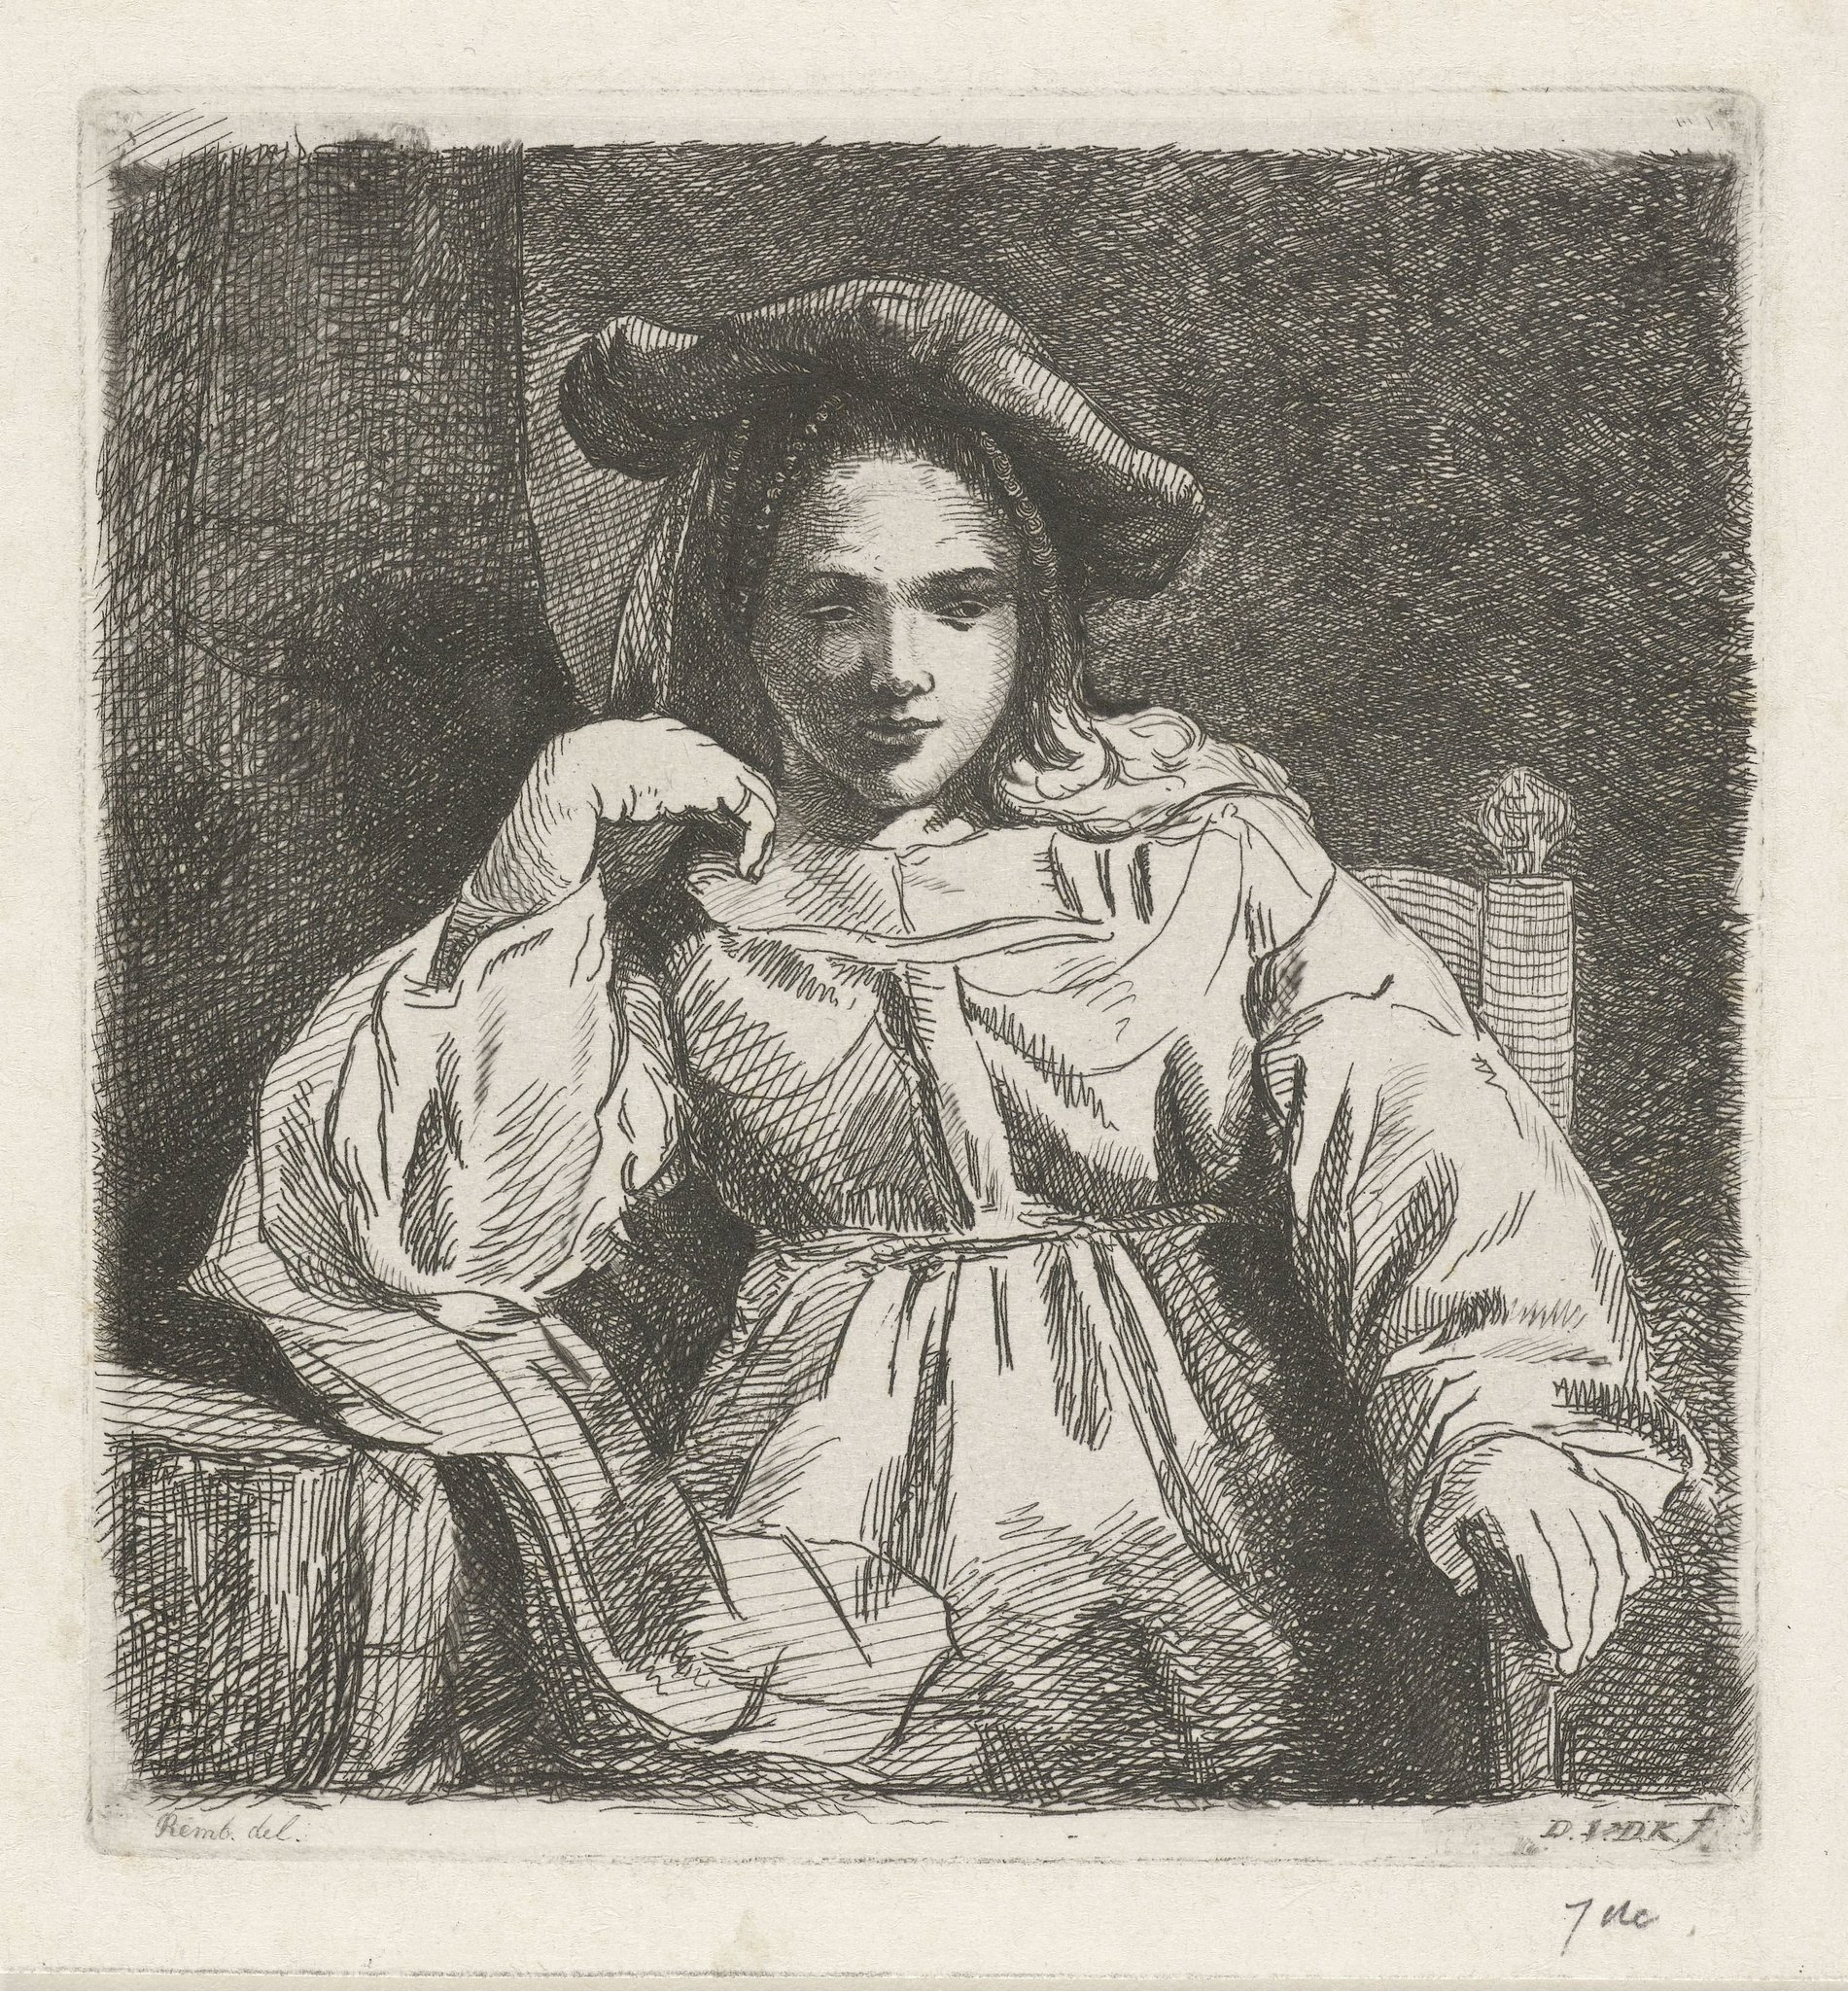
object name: print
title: Zittend meisje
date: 1814-1859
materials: paper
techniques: drypoint, etching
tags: adolescent, young woman, maiden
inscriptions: inscription: ‘7de’, collector's mark: Lugt 2228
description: Een meisje, getooid met een baret, zit in een stoel, terwijl ze met haar elleboog op de tafel naast haar leunt.